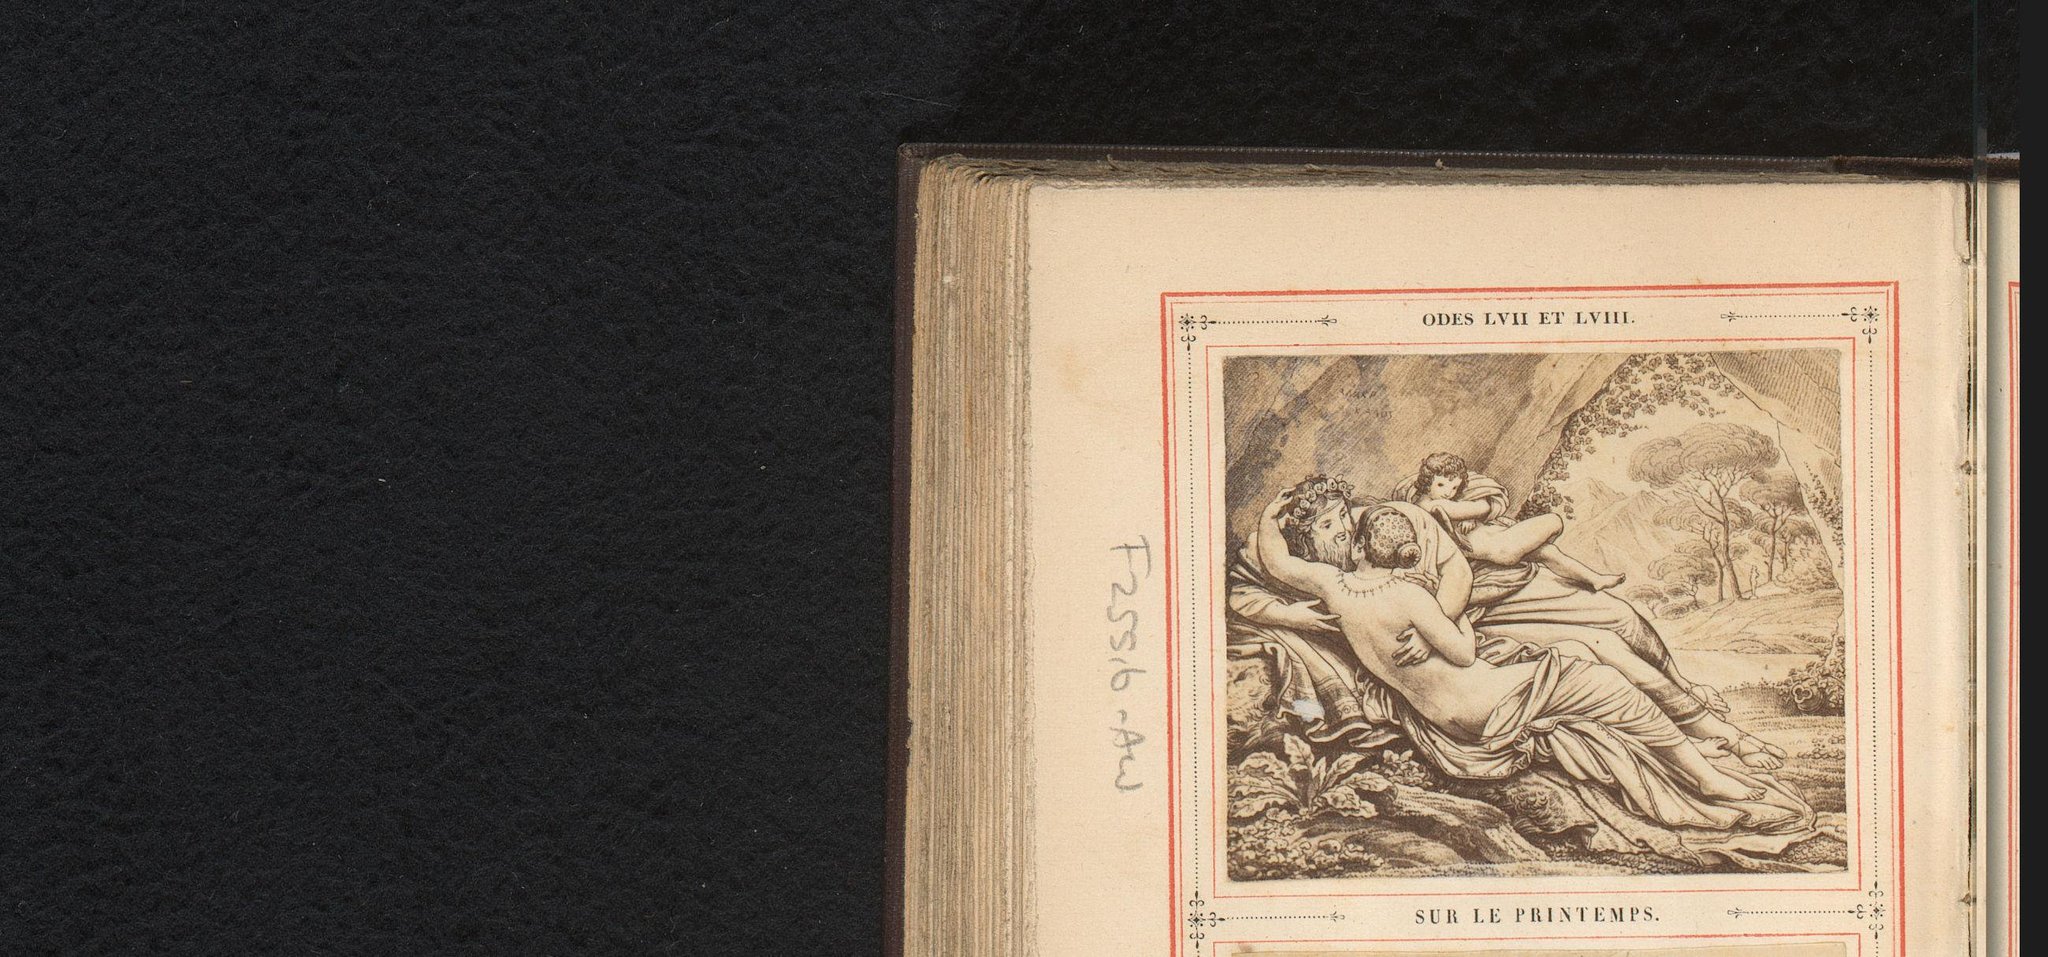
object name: page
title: Sur le printemps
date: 1859-1864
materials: paper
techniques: albumen print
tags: gods ~ classical mythology